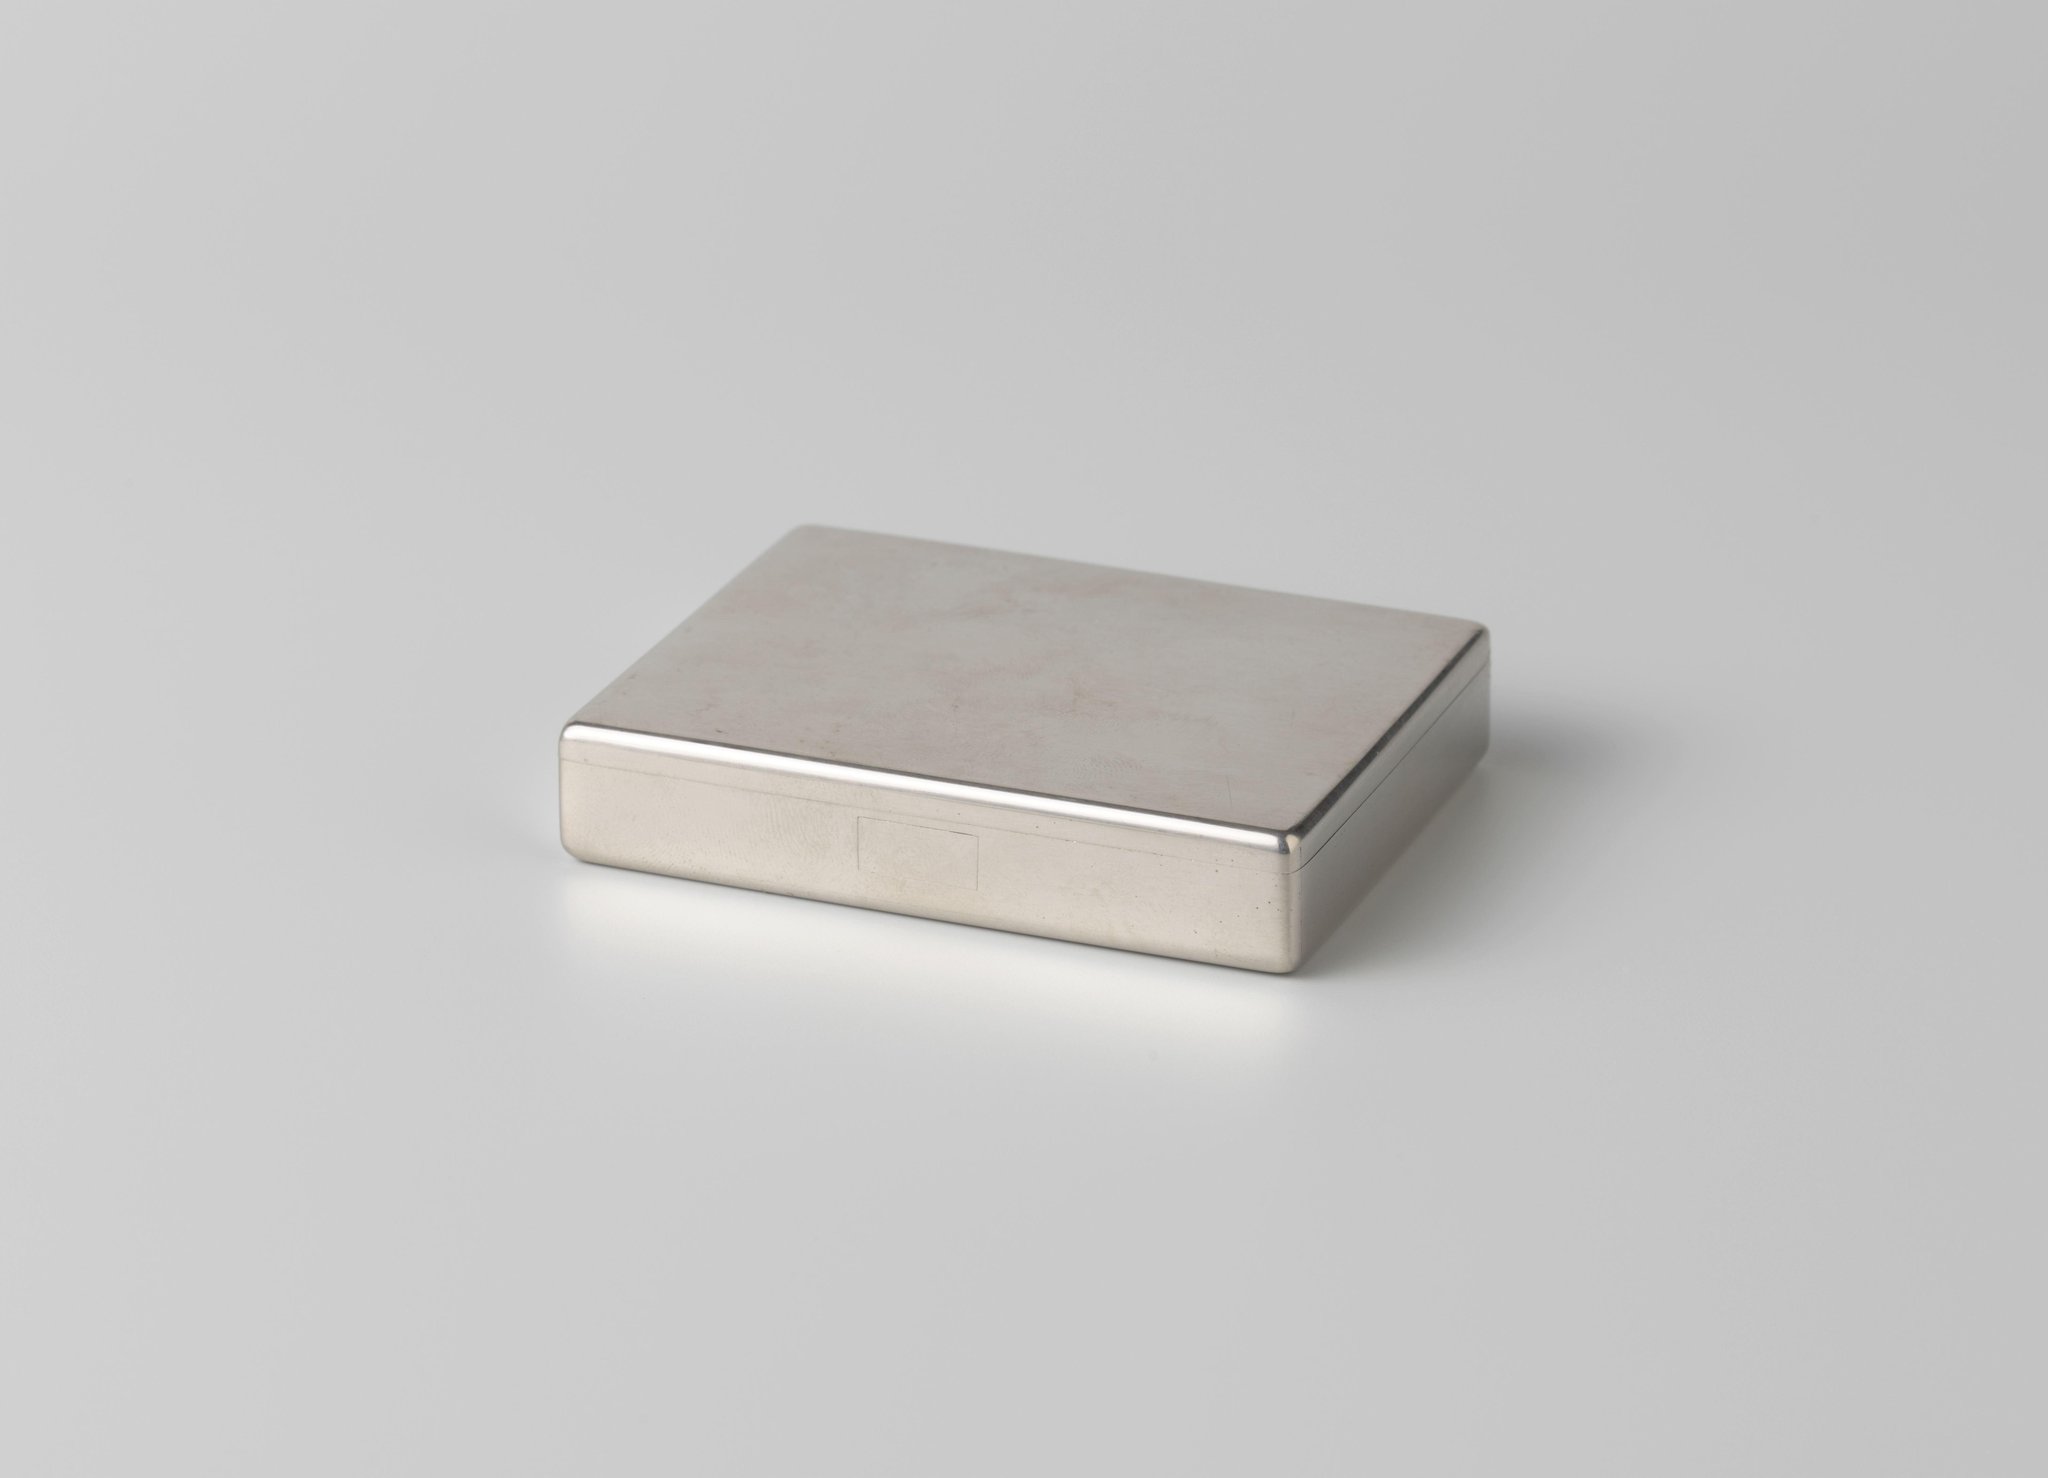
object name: box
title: Doos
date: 1400-1950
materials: metal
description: Doos van verzilverd (?) metaal. Rechthoekig met een zeer hoge glans.